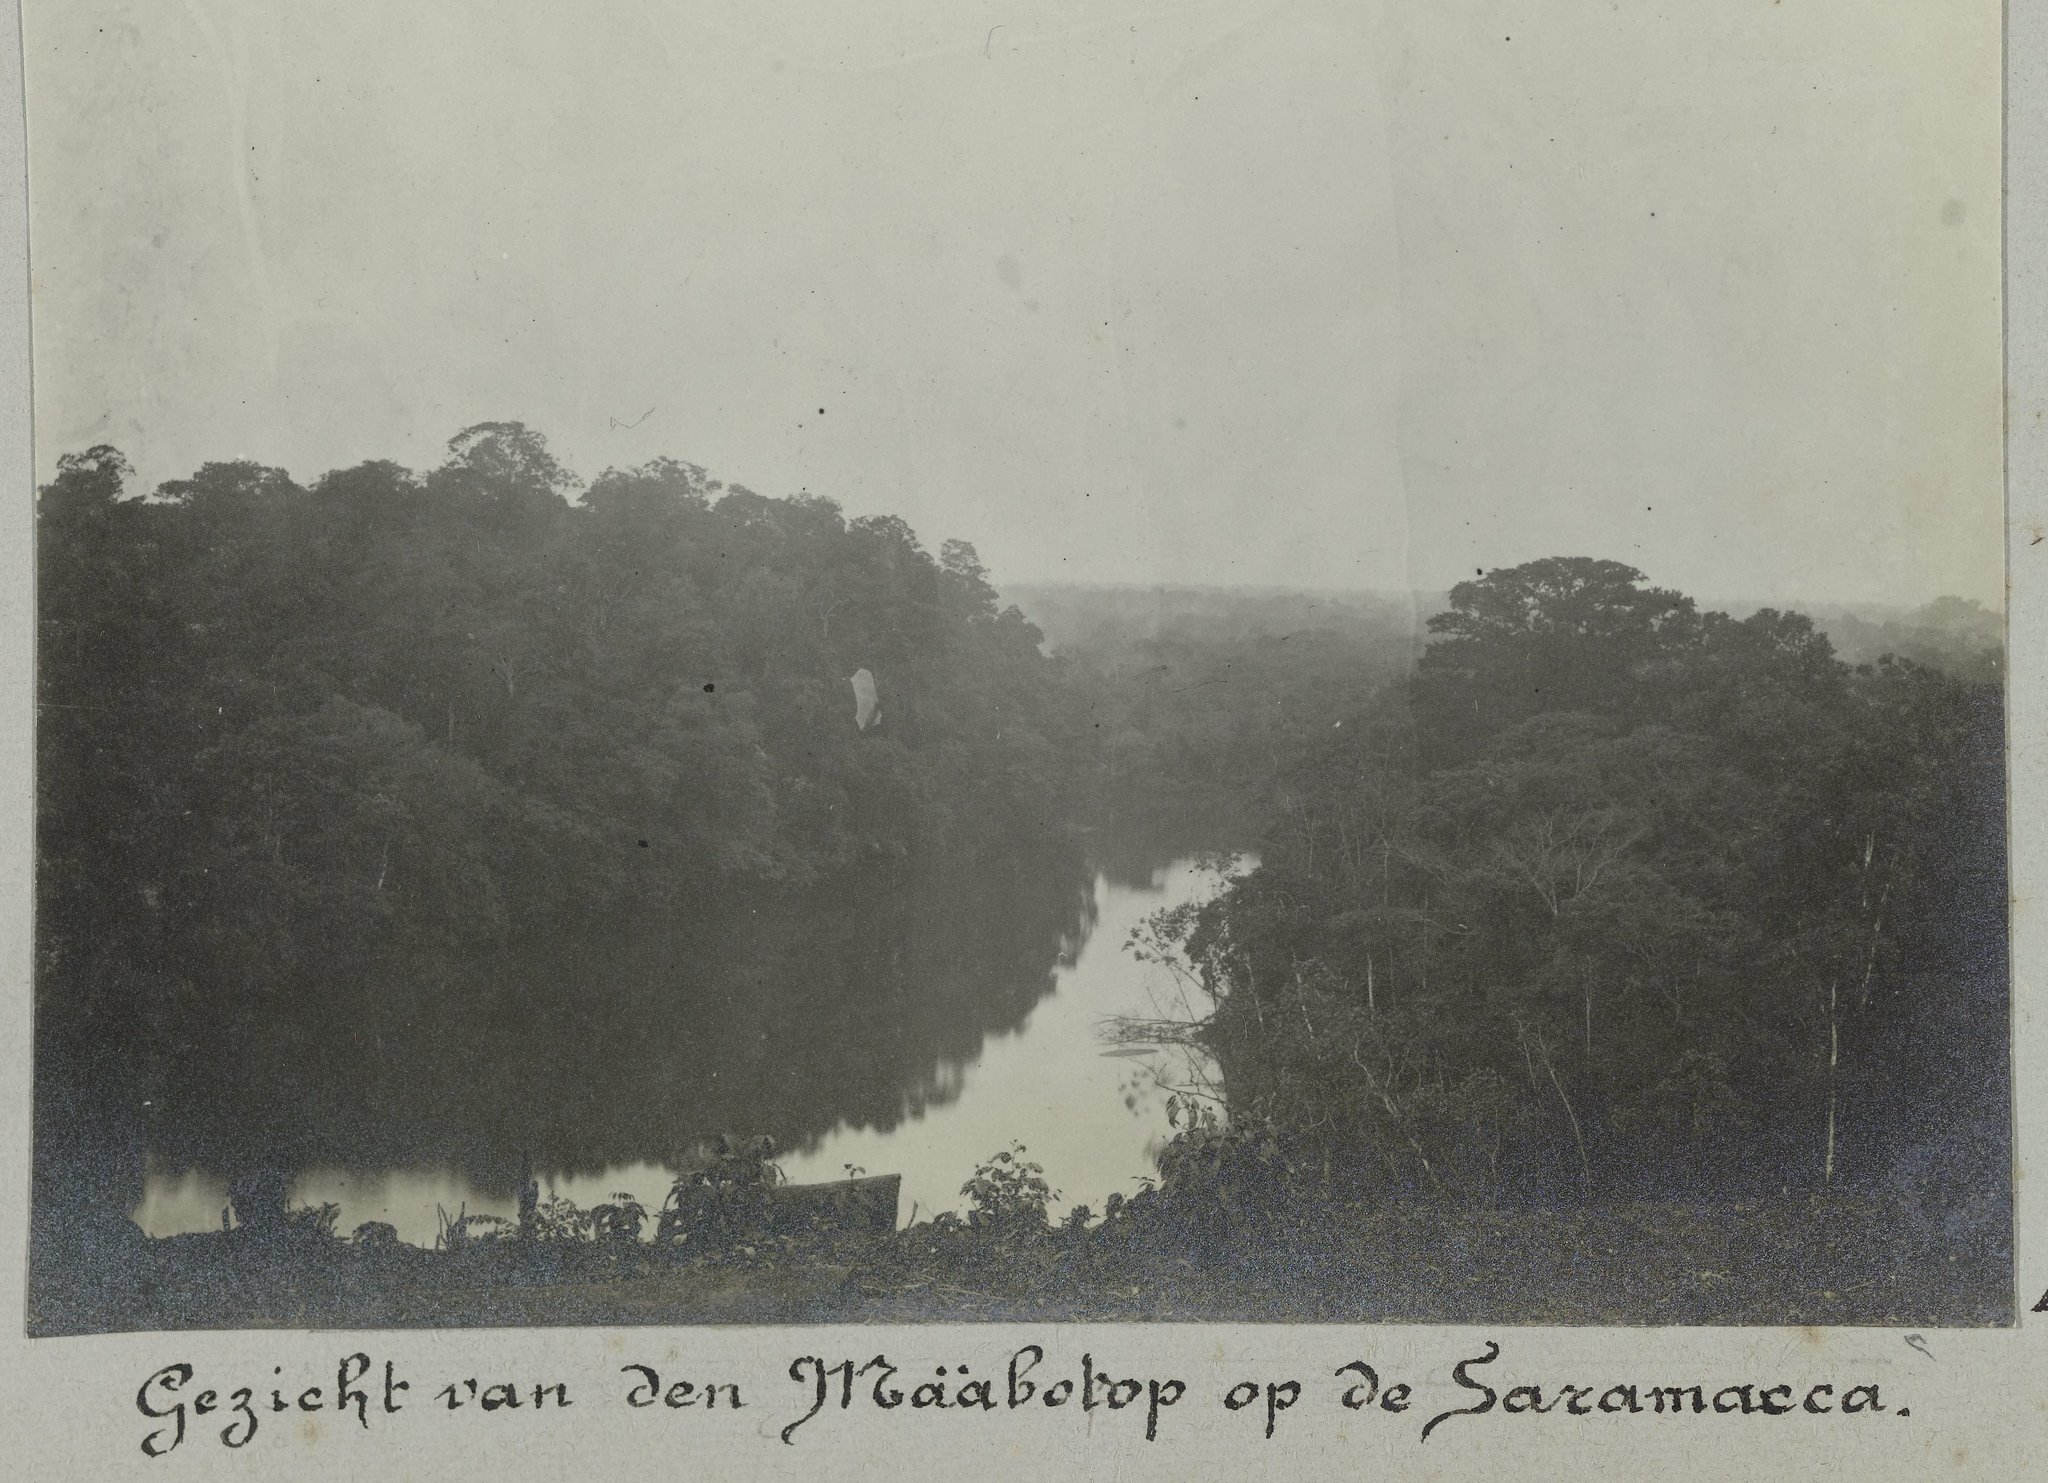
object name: photograph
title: Gezicht van den Mäabotop op de Saramacca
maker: hendrik doijer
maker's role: engineer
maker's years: 1863-1925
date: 1903-1910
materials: photographic support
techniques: gelatin silver print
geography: suriname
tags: suriname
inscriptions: inscription: ‘4. / Gezicht van den Mäabotop op de Saramacca.’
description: Gezicht vanaf de top van de Maabo Heuvel op de Saramacca Rivier. Onderdeel van het fotoalbum Souvenir de Voyage (deel 1), over het leven van de familie Doijer in en rond de plantage Ma Retraite in Suriname in de jaren 1903-1910.